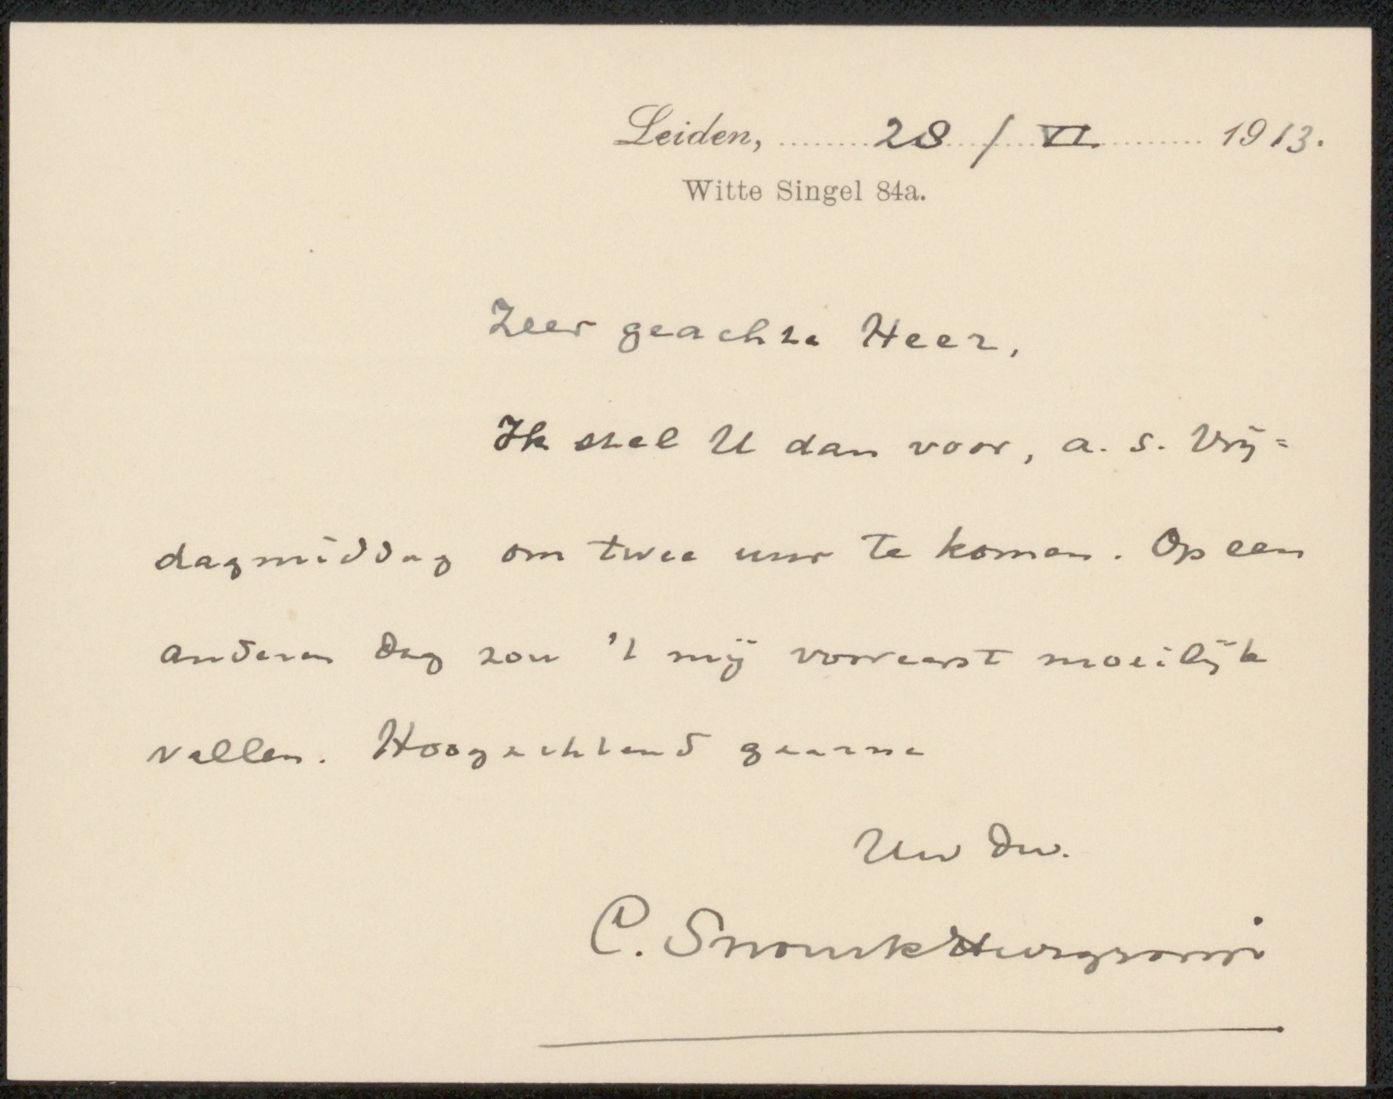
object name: letter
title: Brief aan Philip Zilcken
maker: christiaan snouck hurgronje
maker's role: fotograaf, schrijver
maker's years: 1857-1936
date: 1913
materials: cardboard, ink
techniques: pen, printing, writing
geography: leiden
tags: the hague, painter, draughtsman, philip zilcken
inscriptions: collector's mark: ‘RPK’